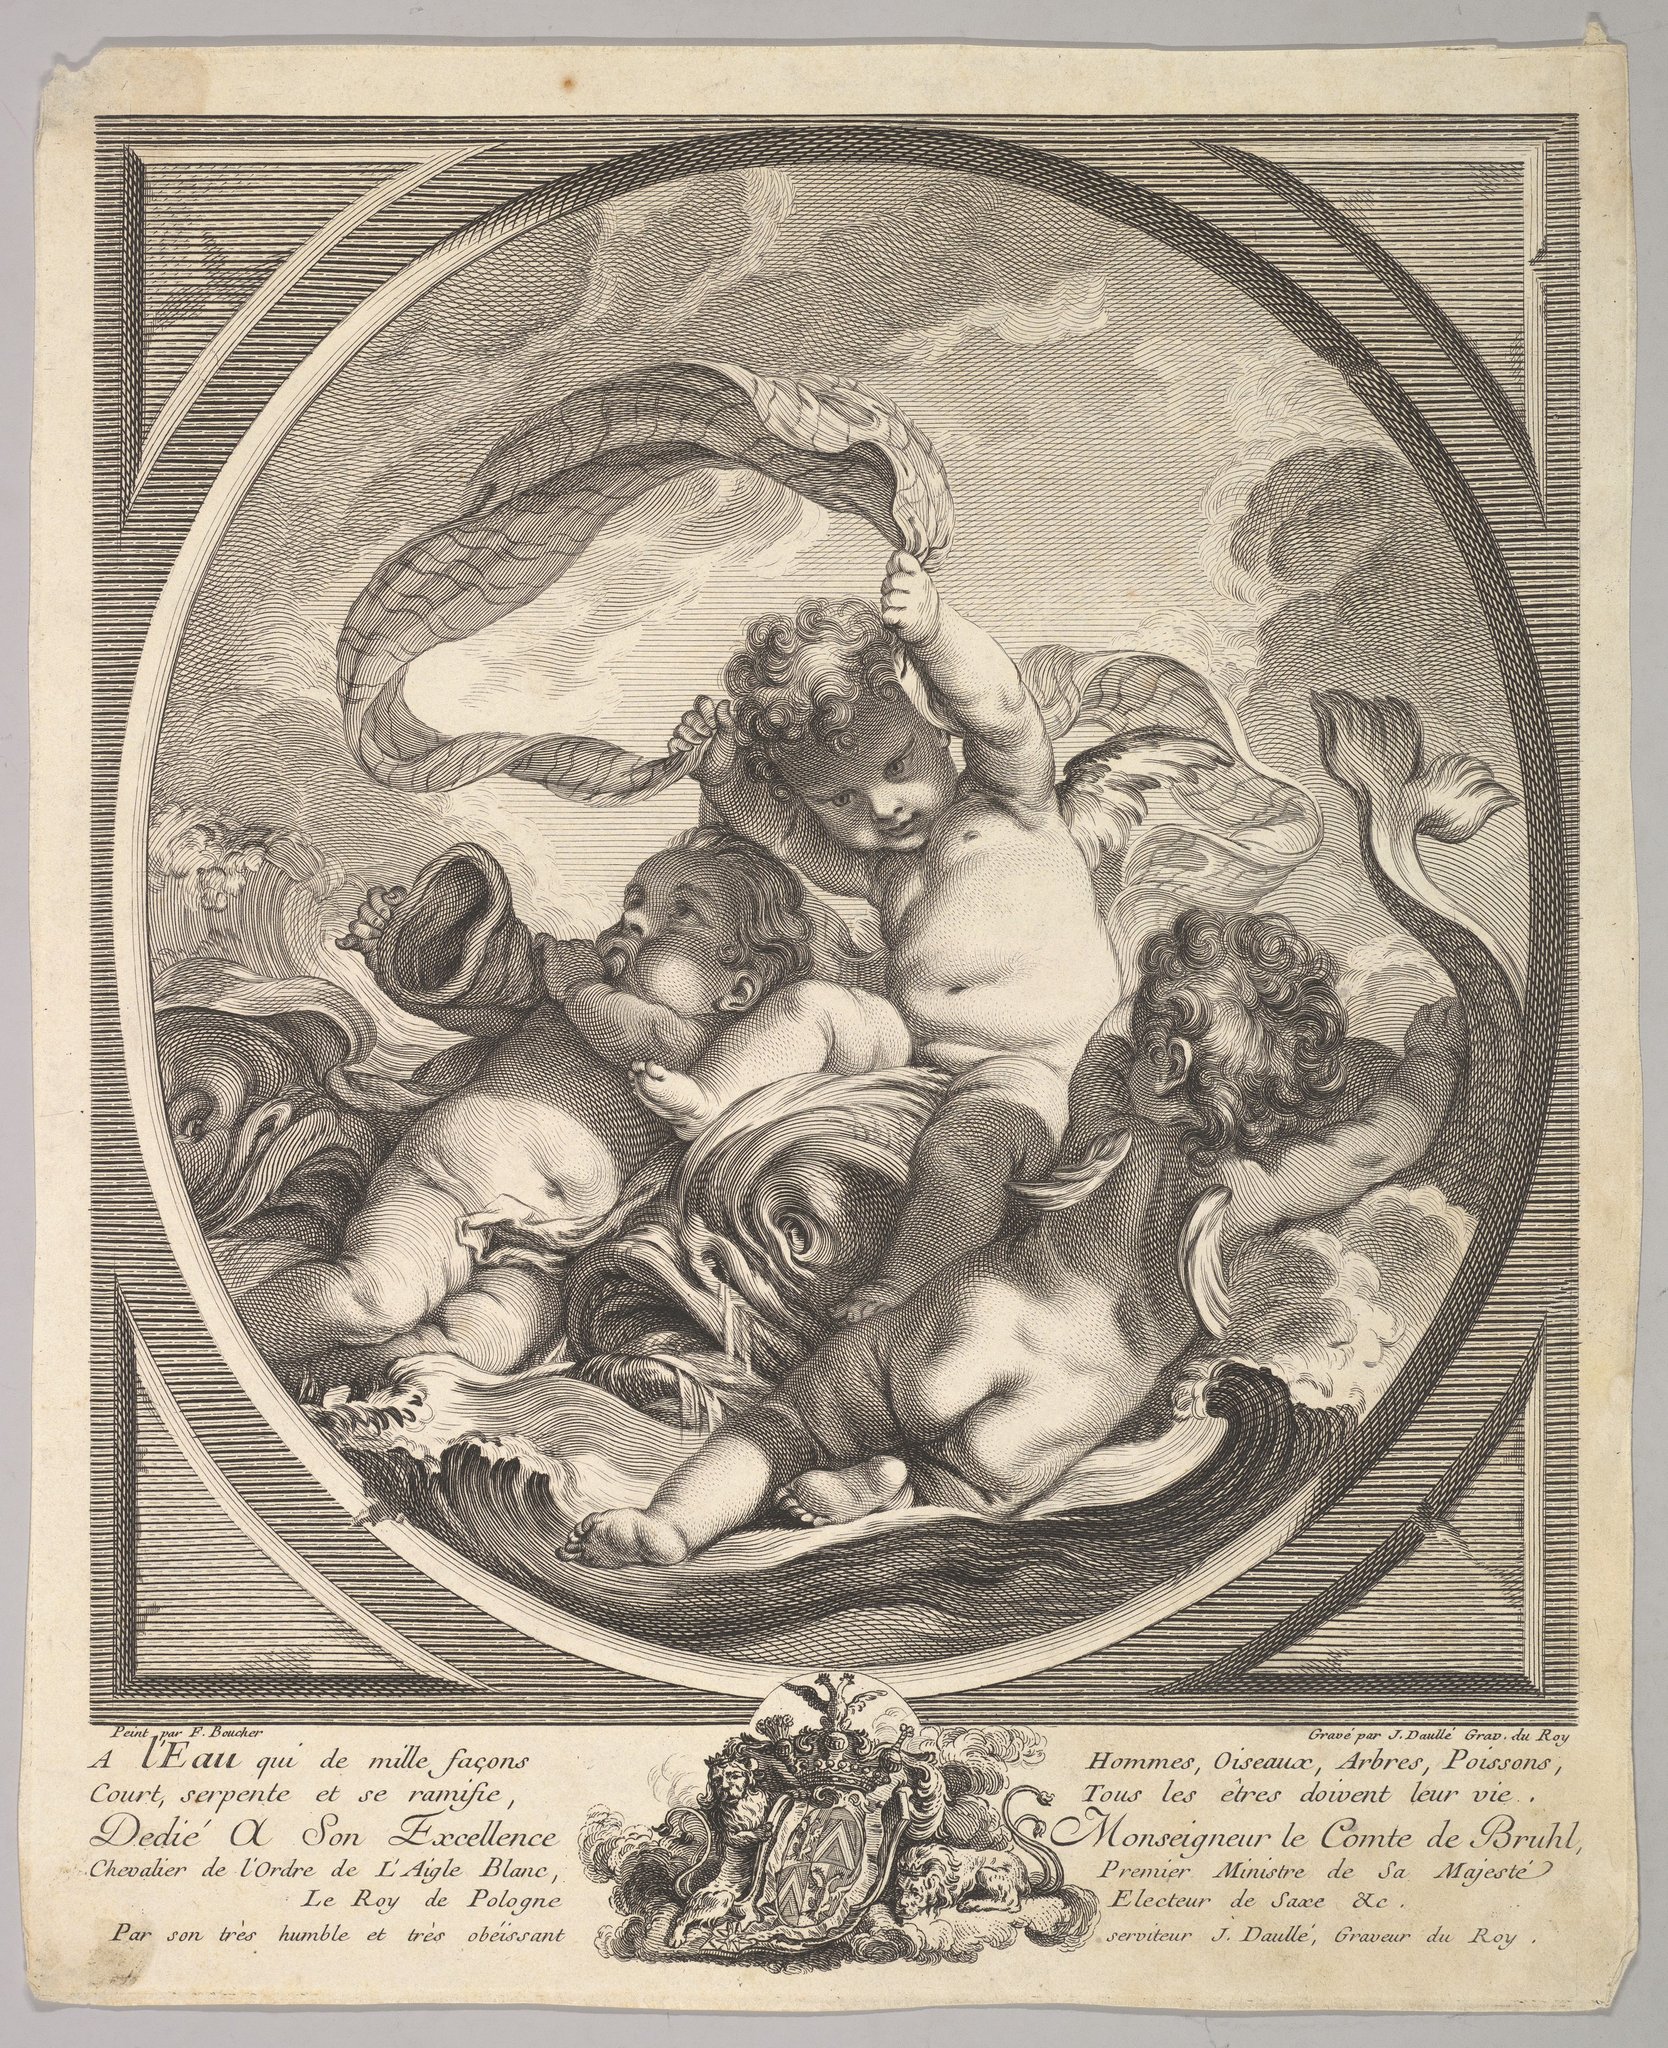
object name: print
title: Water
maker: jean daullé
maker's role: artist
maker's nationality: french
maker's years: 1703-1763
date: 1748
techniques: engraving, etching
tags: music,horns,coat of arms